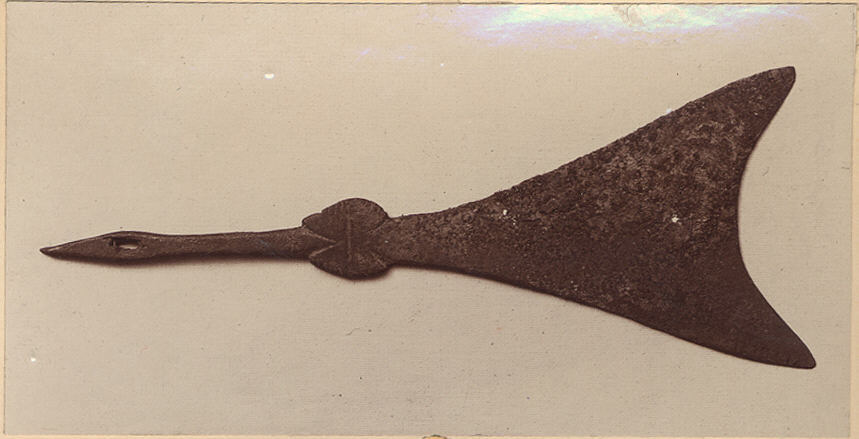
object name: knife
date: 501-600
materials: iron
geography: egypt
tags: knives